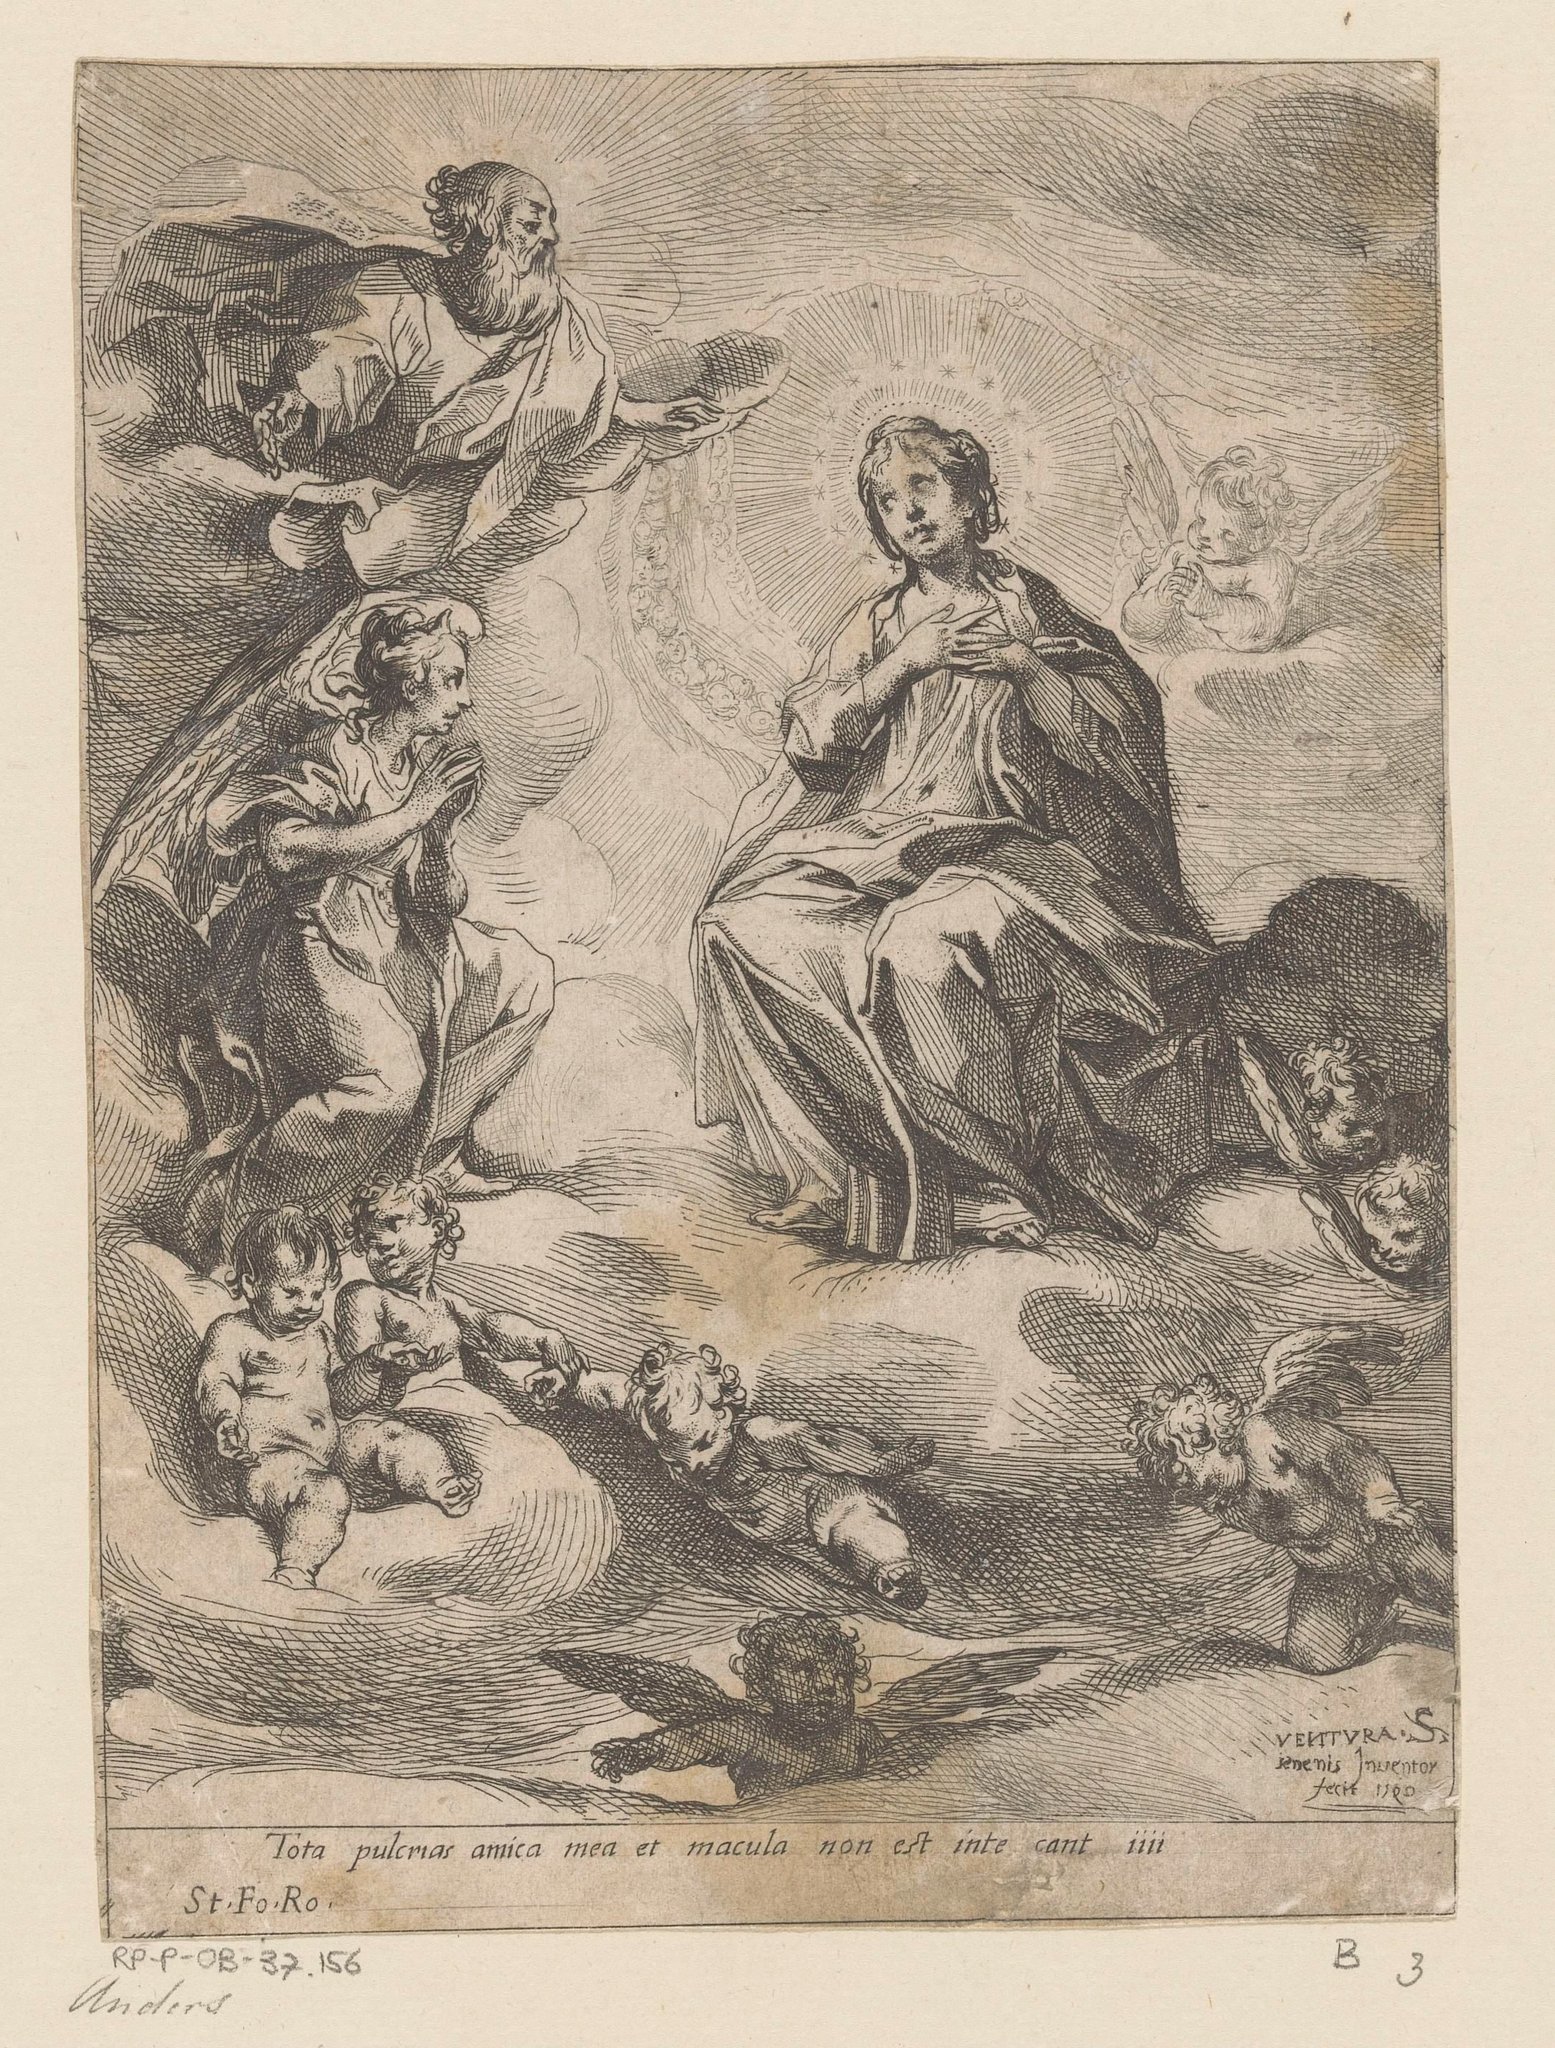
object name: print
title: Bestemming van de Maagd Maria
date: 1590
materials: paper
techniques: etching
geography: rome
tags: the virgin mary, god the father, cupids: 'amores', 'amoretti', 'putti', angels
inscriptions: collector's mark: Lugt 240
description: God de Vader en engelen verschijnen aan de heilige Maagd Maria op wolken. Titel in het Latijn in ondermarge.